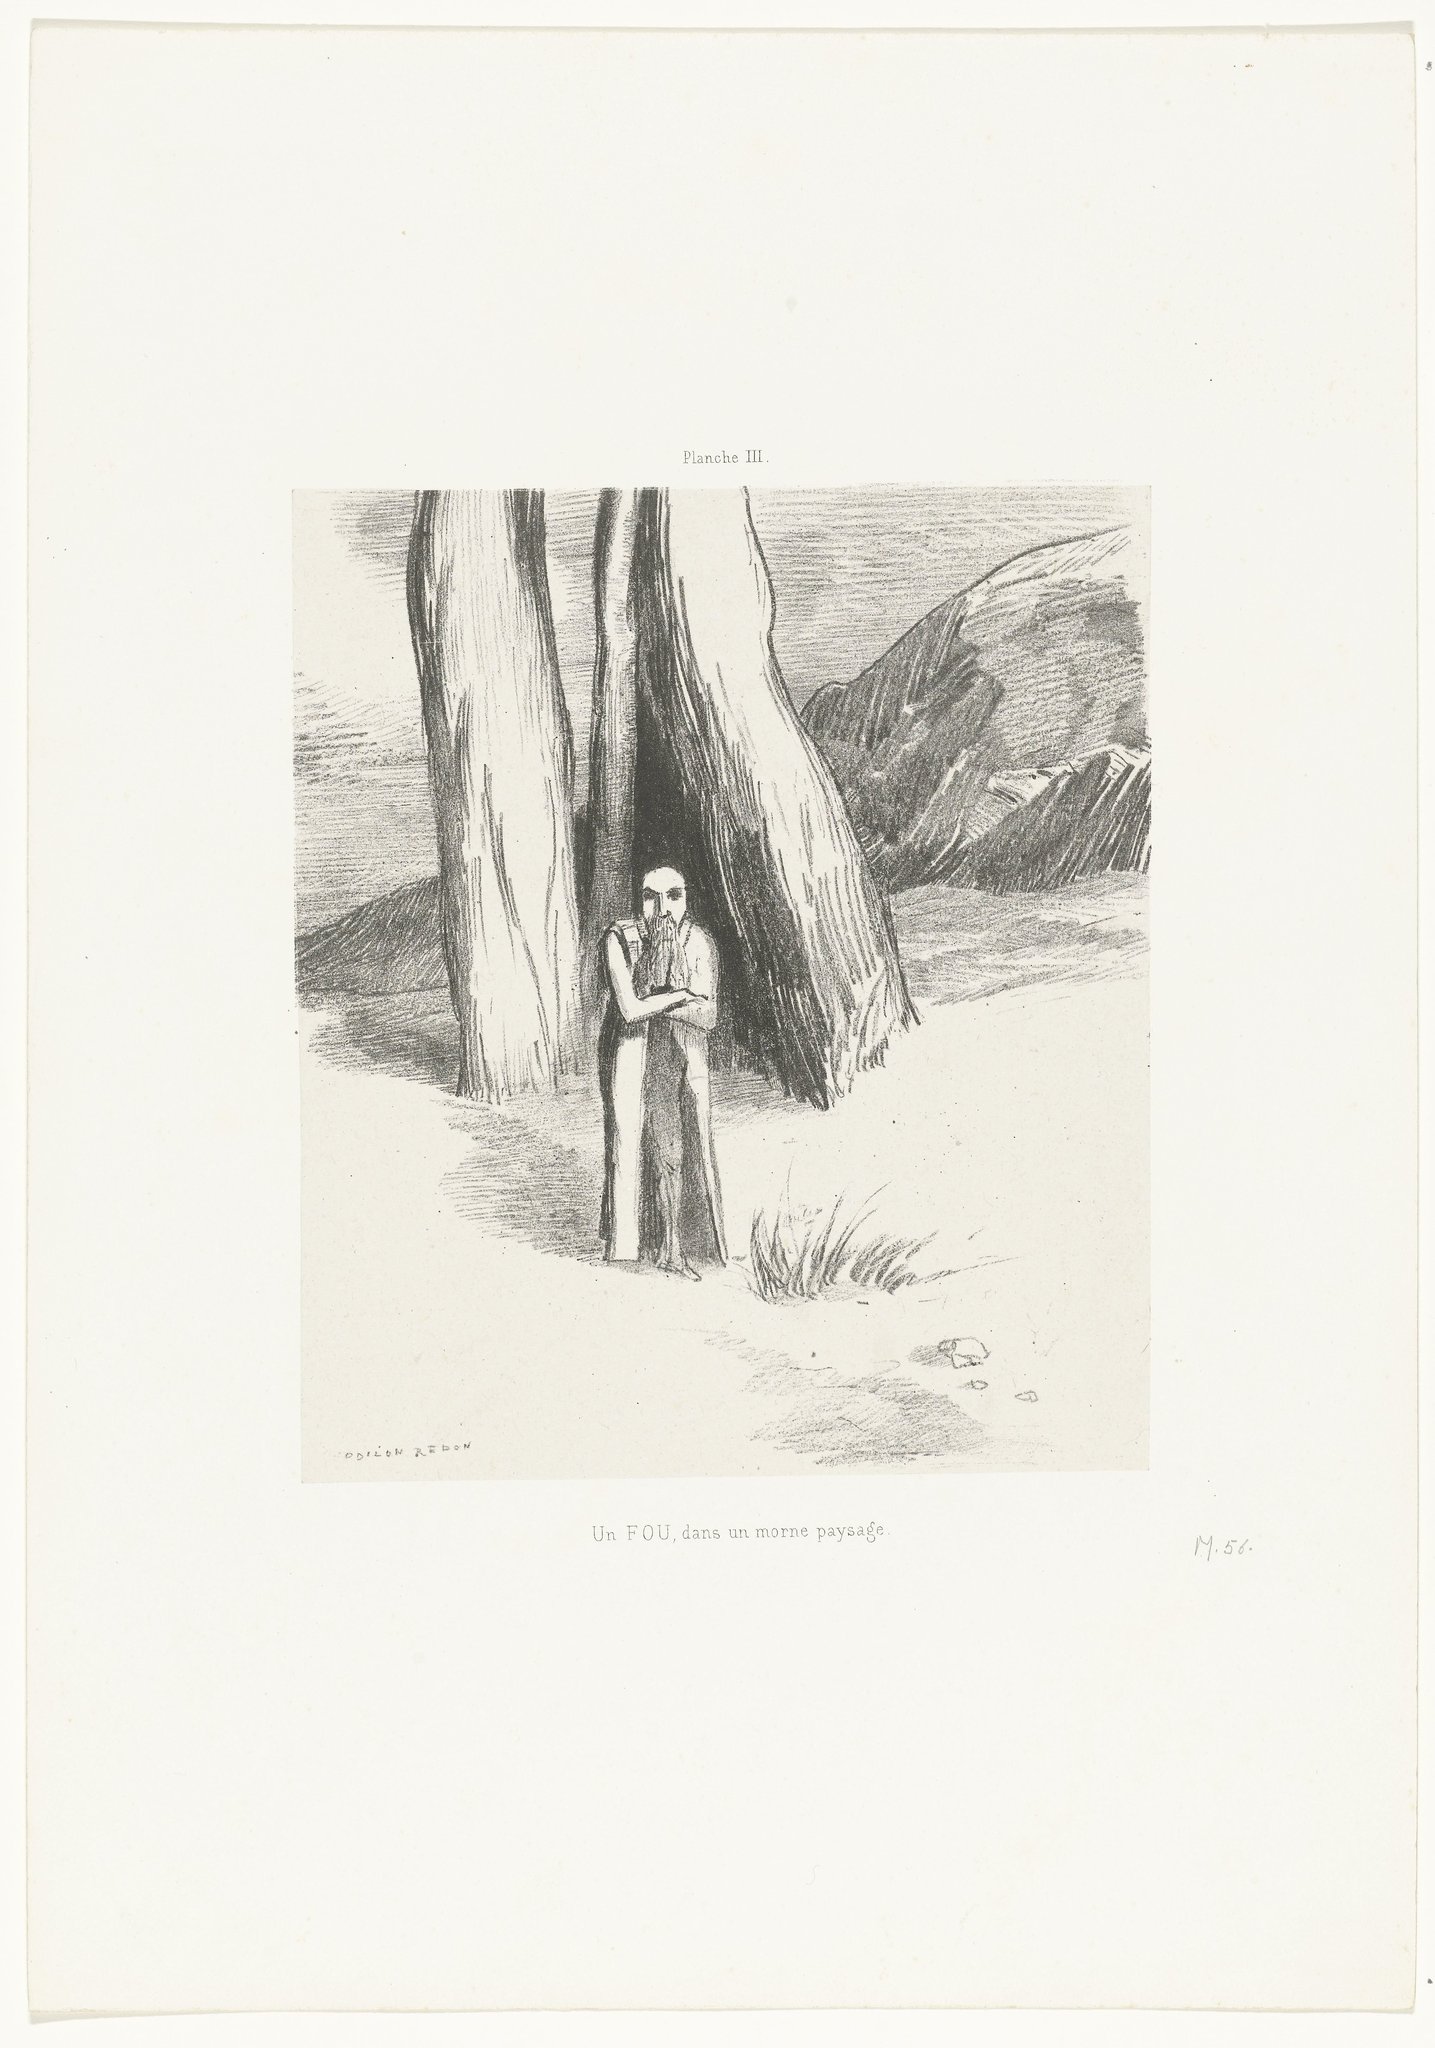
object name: print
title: Un FOU, dans un morne paysage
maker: odilon redon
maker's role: draughtsman, painter, print maker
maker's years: 1840-1916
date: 1885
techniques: printmaking, lithograph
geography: paris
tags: adult man, madness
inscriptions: collector's mark: Lugt 2228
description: Een man, met een lange baard en mantel, staand in een landschap. Derde prent van zes uit het album "Hommage a Goya".